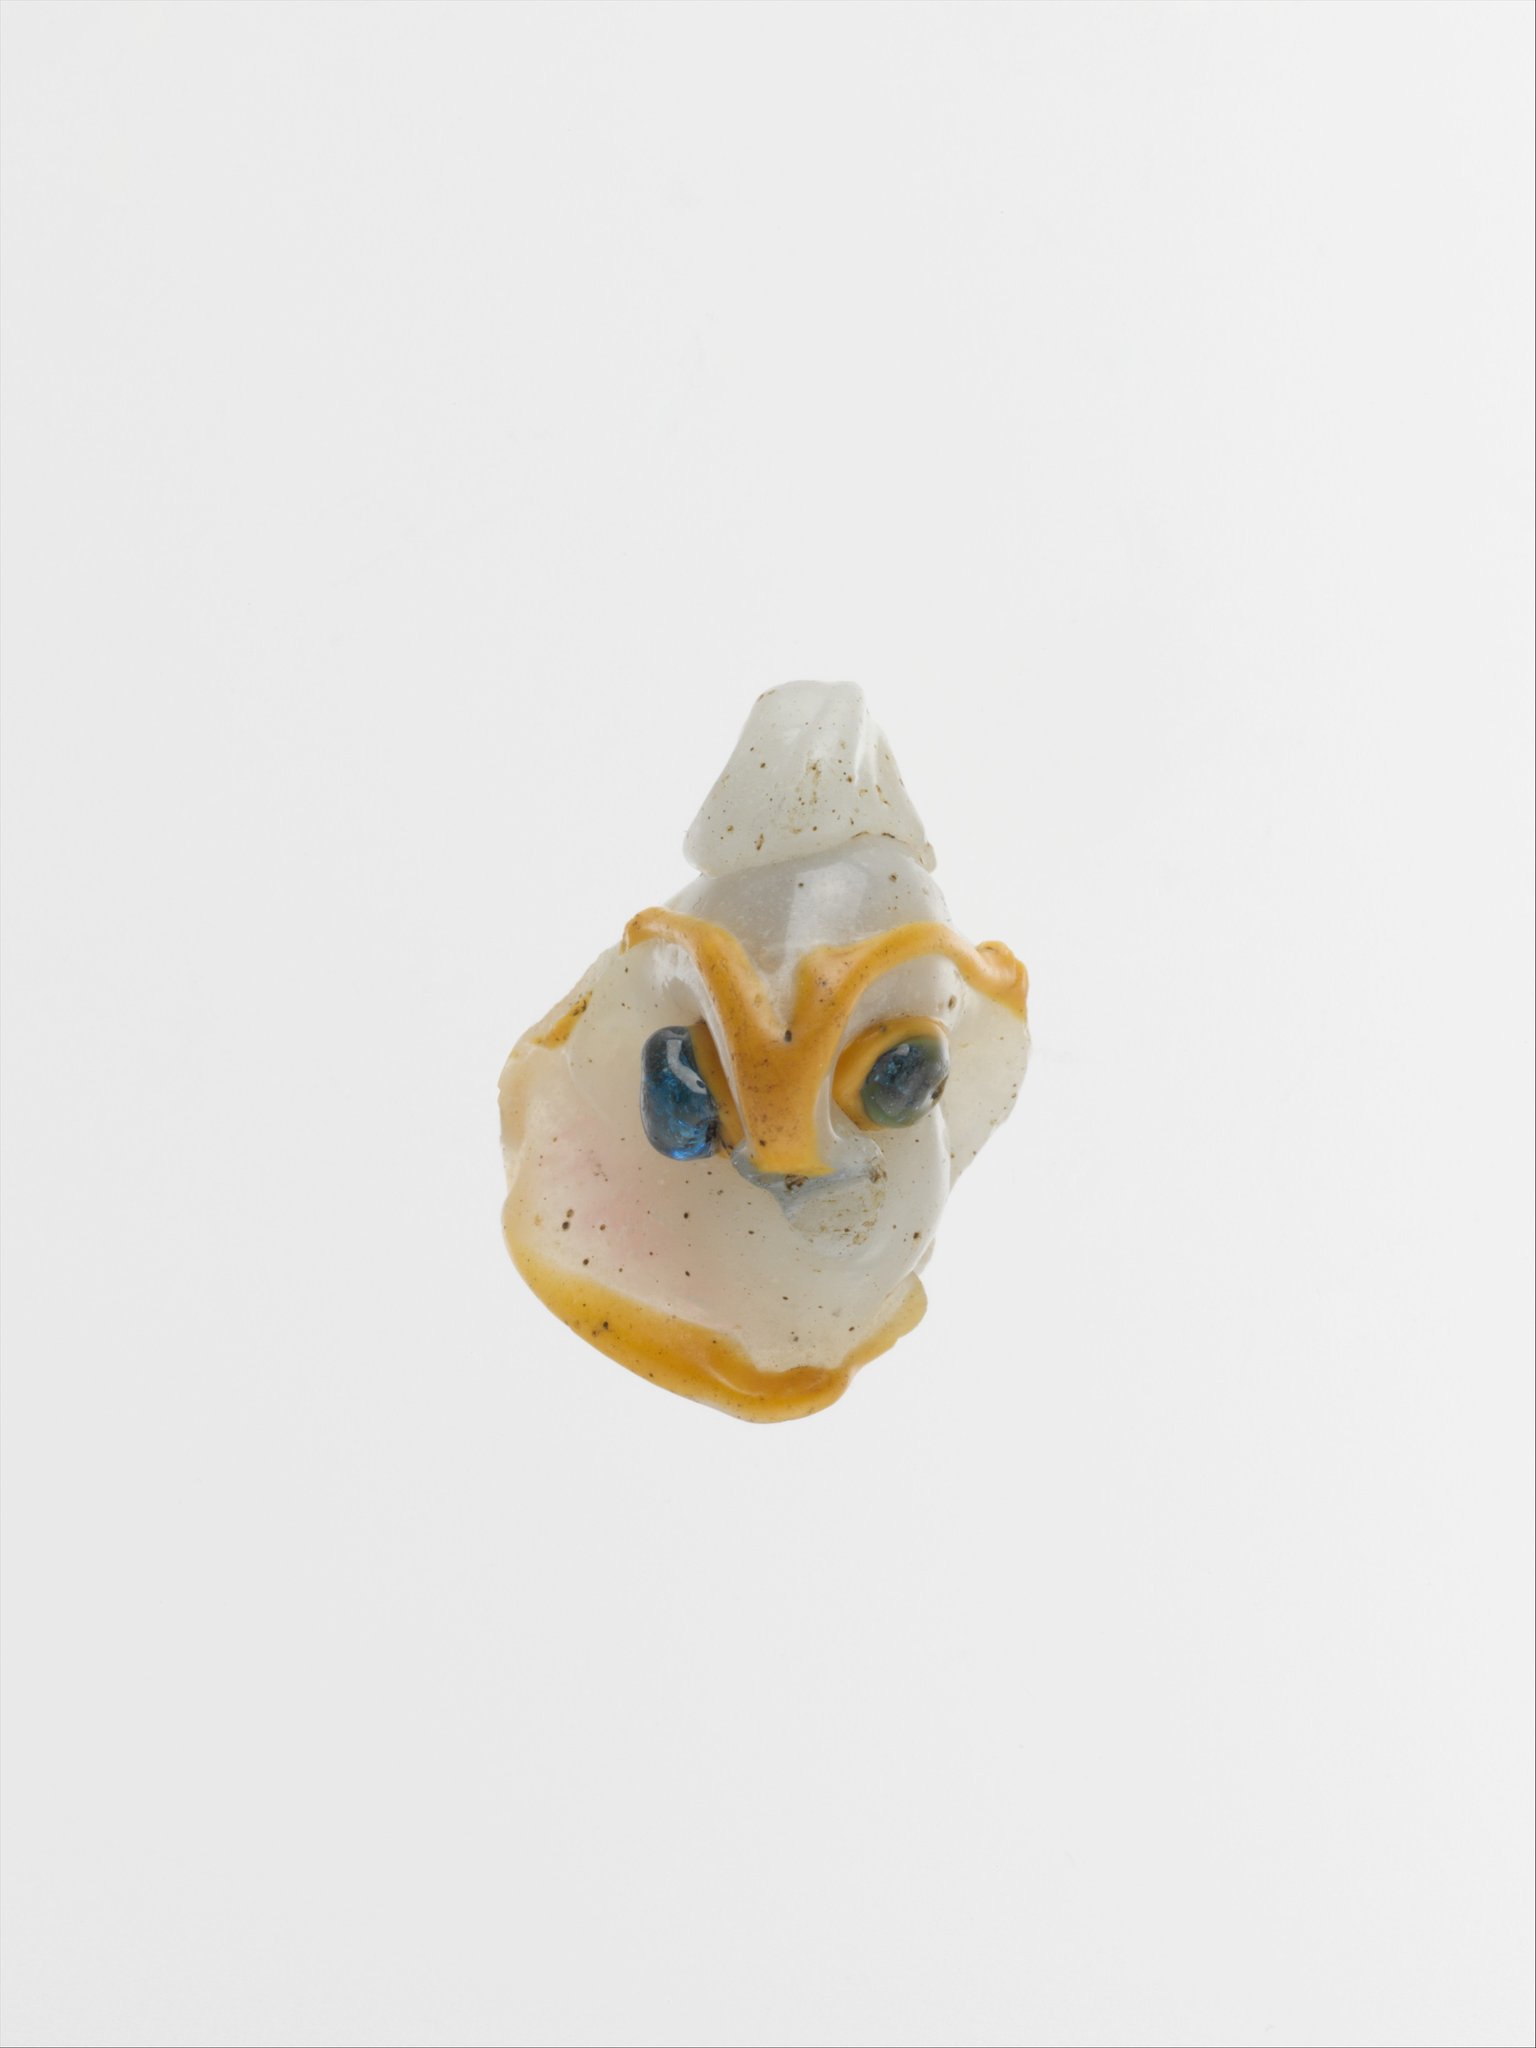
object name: head pendant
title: Glass pendant in the form of a demonic mask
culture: phoenician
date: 600-401 BCE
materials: glass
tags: masks